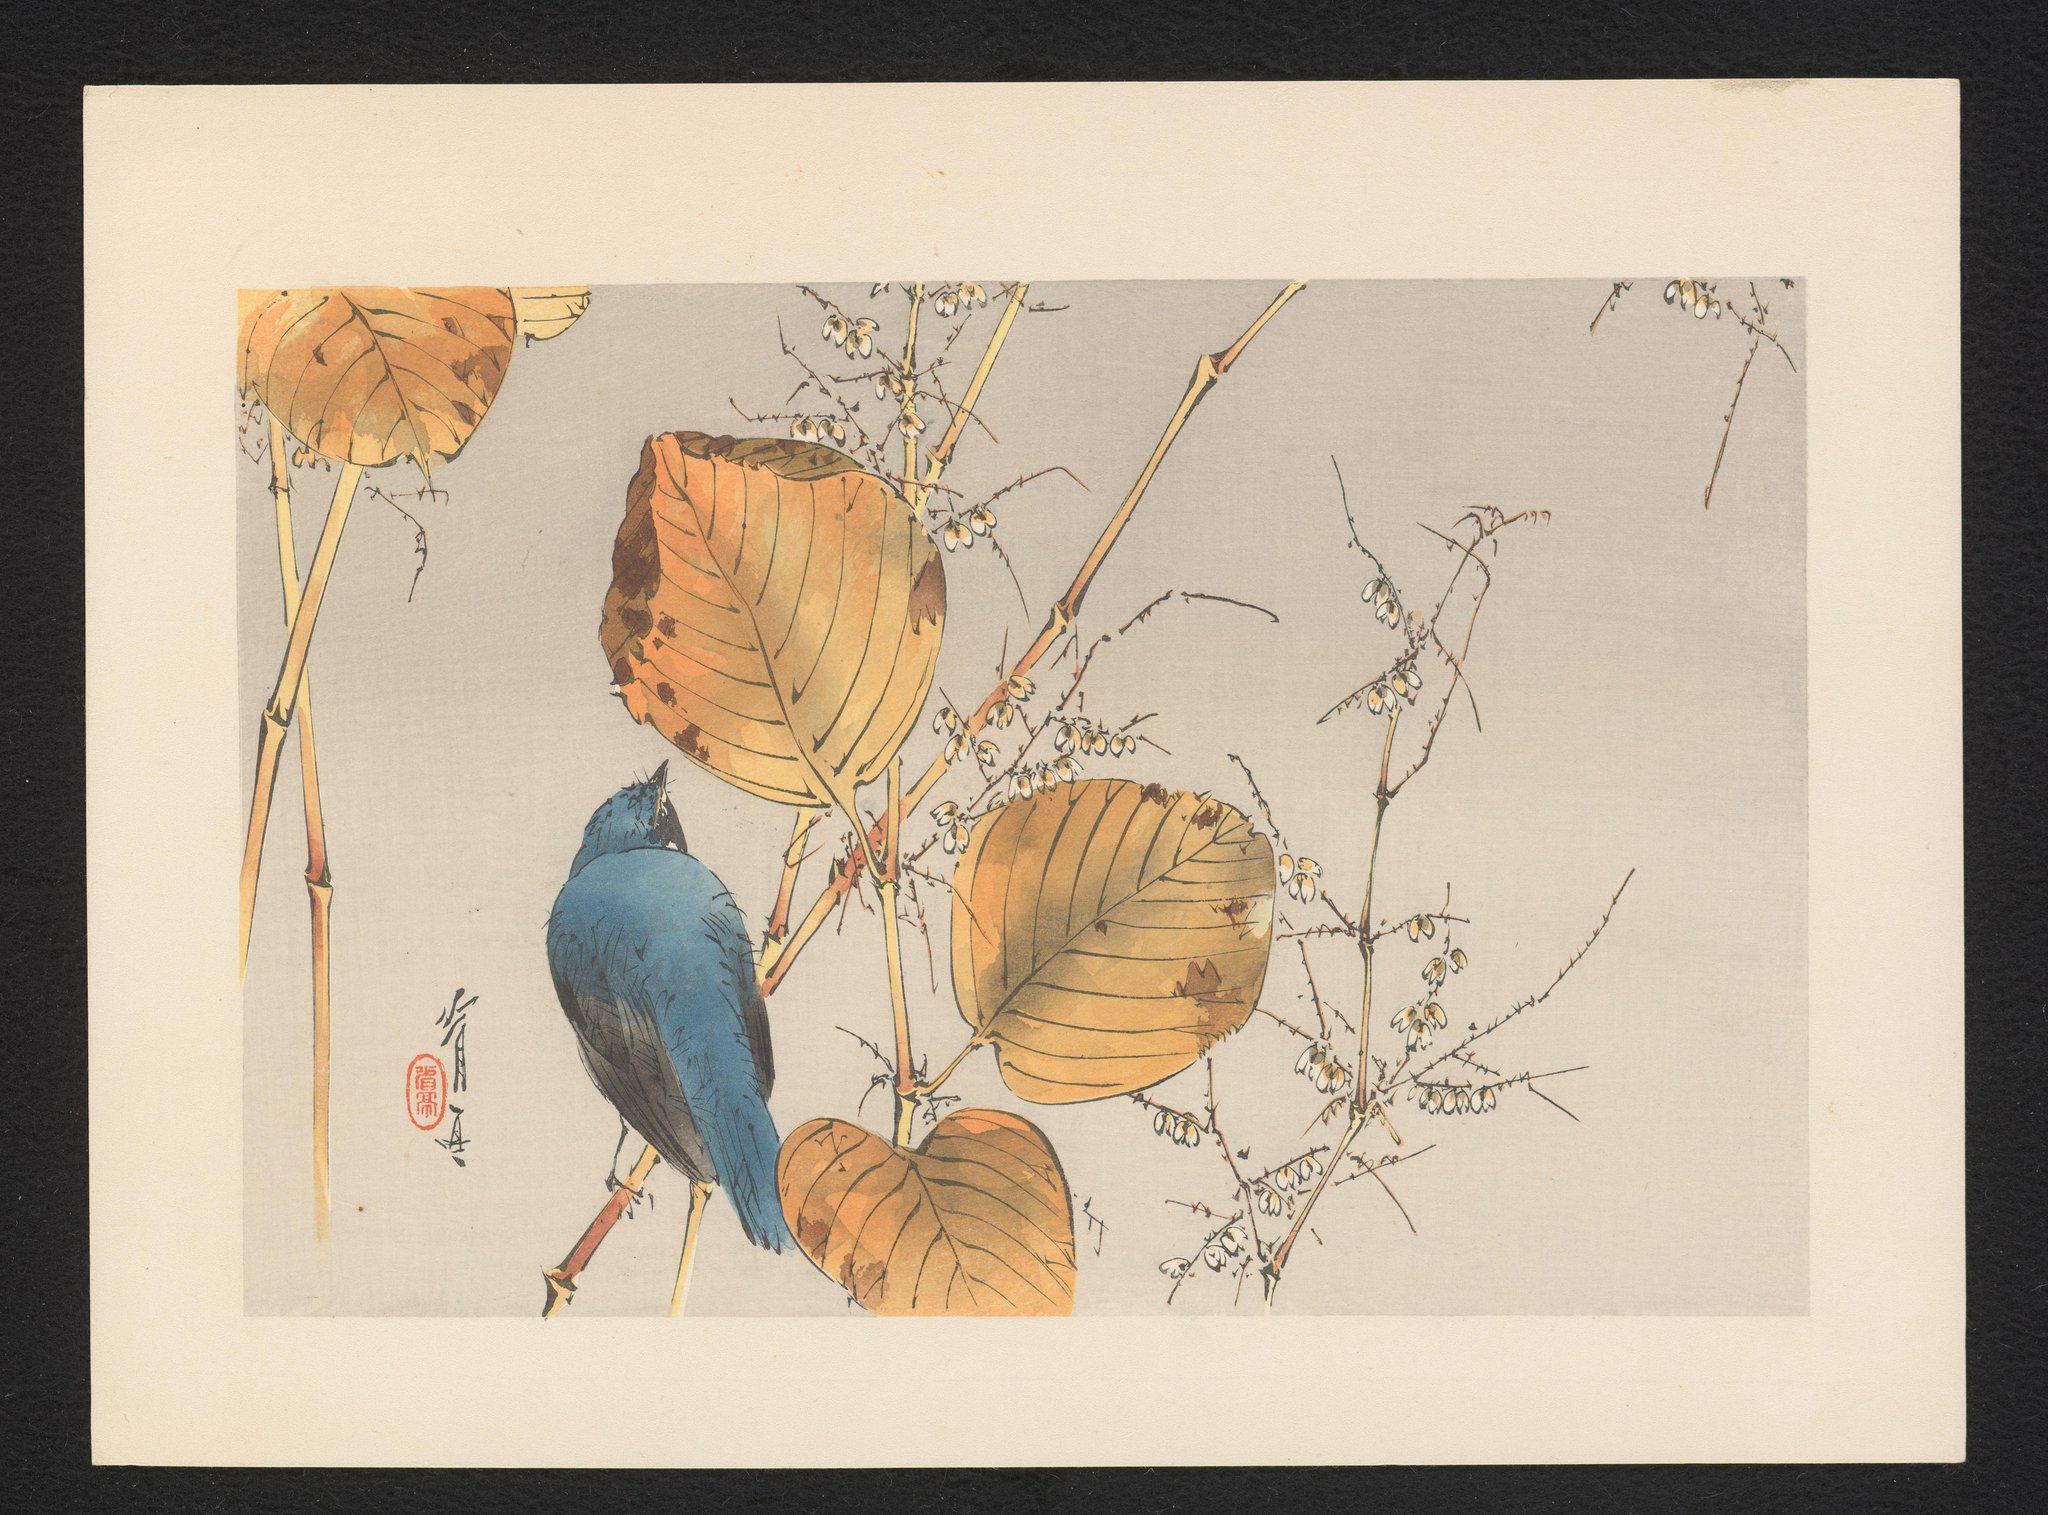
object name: print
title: Bloemen en vogels door Seitei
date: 1916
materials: paper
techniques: woodcut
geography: tokyo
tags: birds